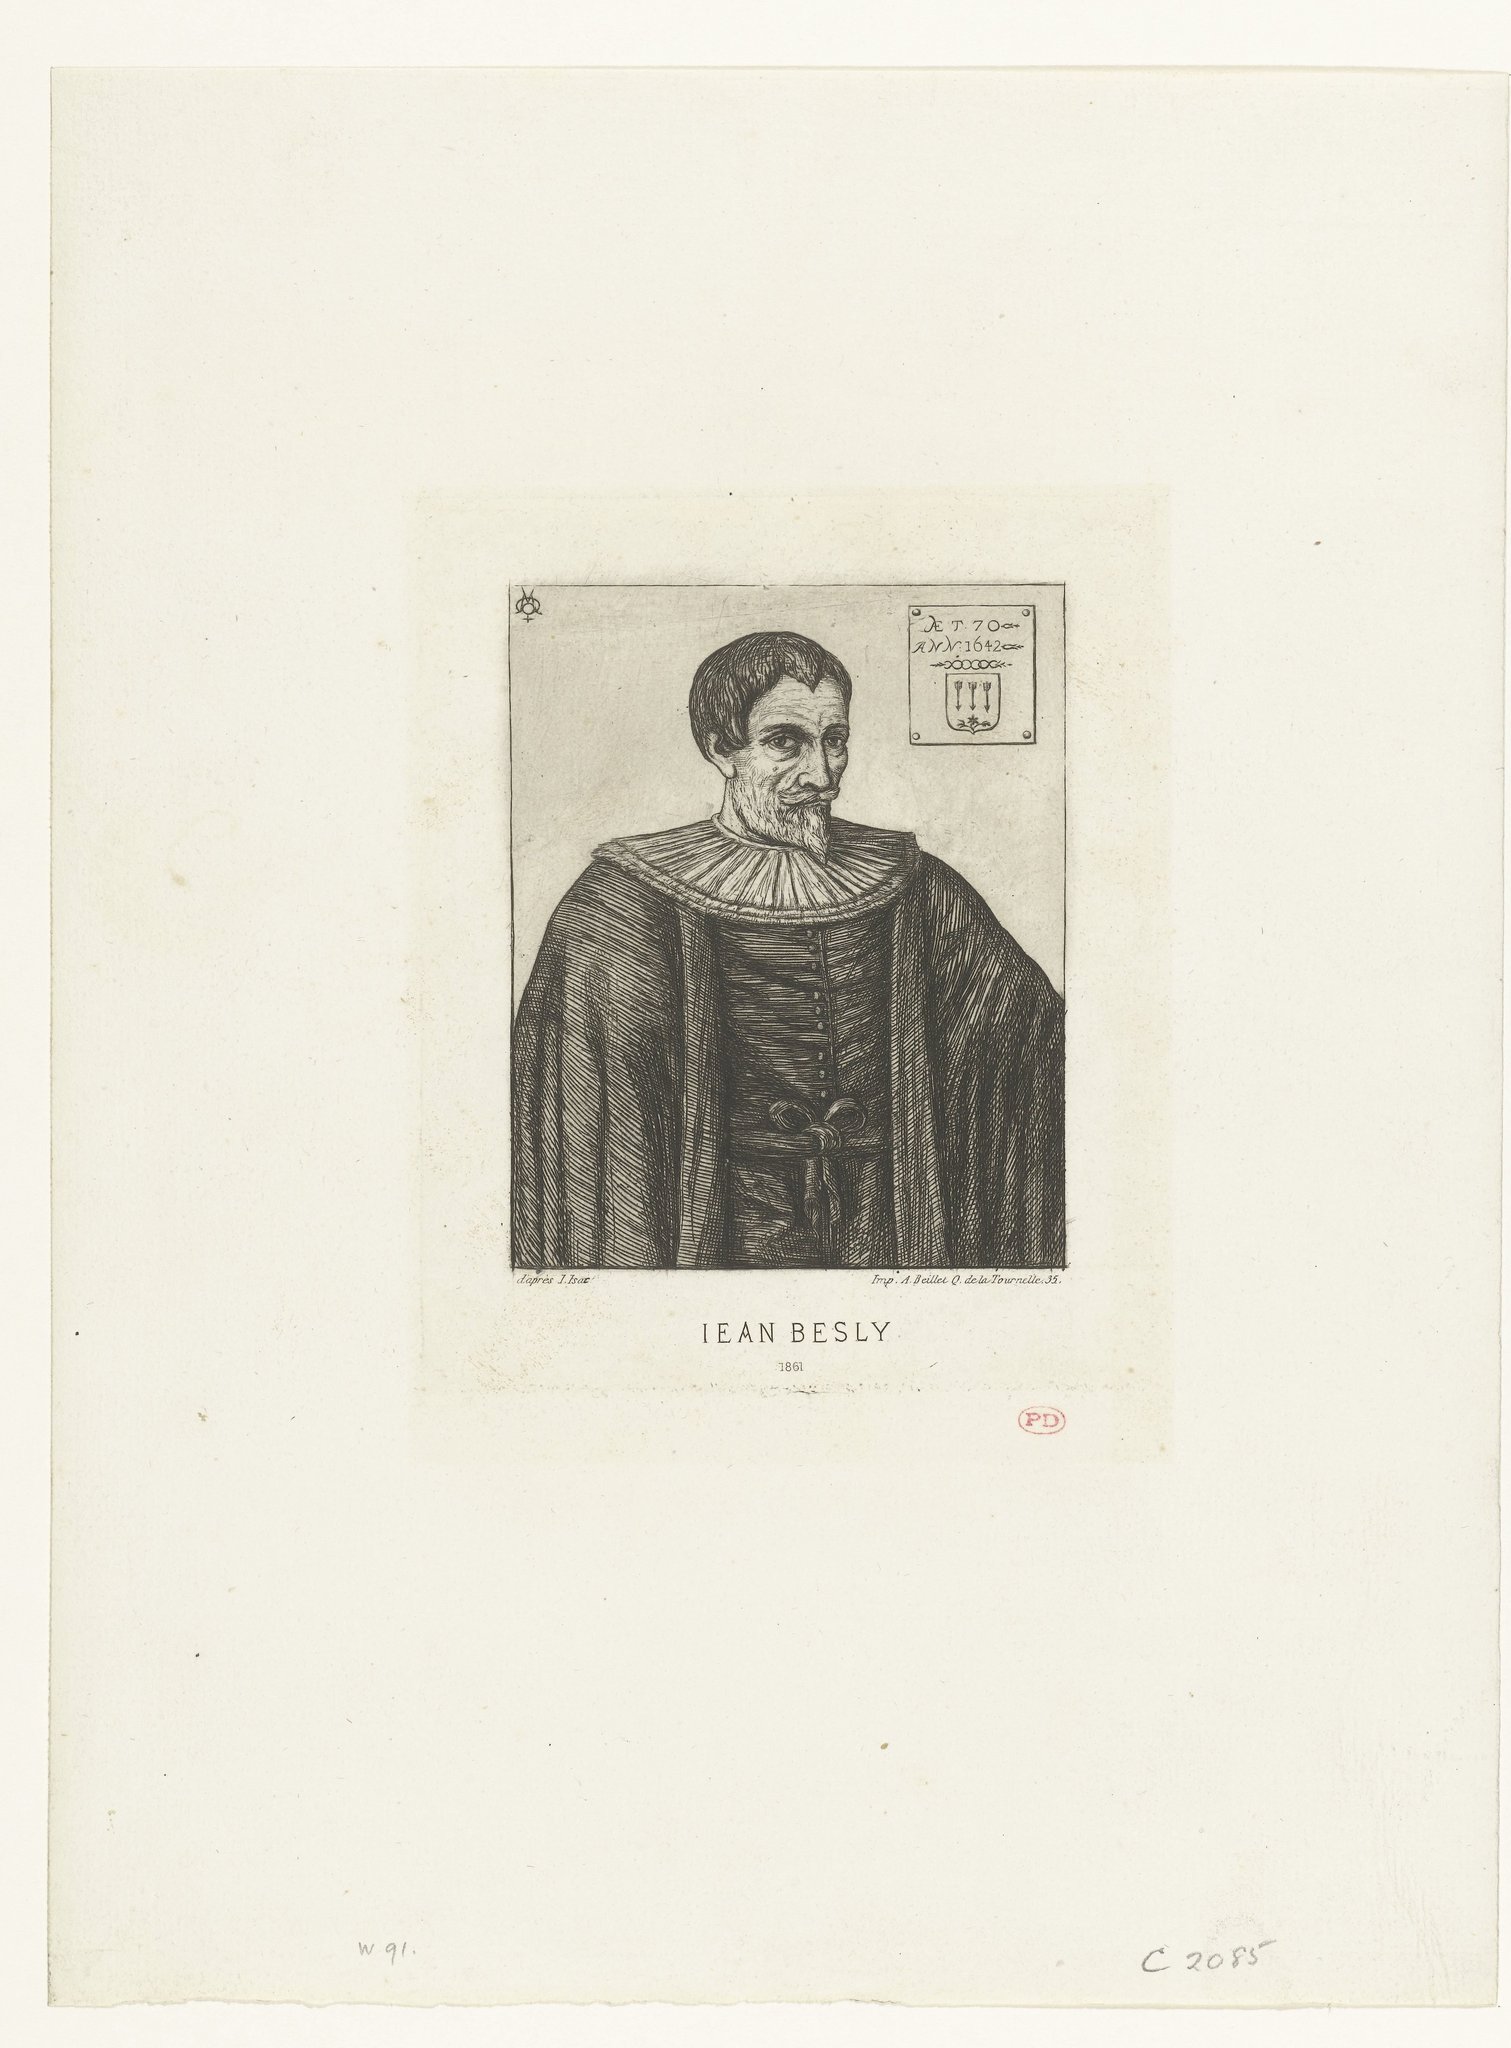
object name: print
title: Jean Besly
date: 1861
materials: paper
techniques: etching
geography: france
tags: historical disciplines; philology (+ portrait of scholar, scientist)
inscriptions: collector's mark: Lugt 2074, collector's mark: stempel R. Vroom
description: Kopie naar prent van Jaspar Isaac. Het portret van deze historicus uit de Franse provincie Poitou werd gepubliceerd in: Fillon, Benjamin & O. de Rochebrune, Poitou et Vendée, études historique et artistique (Delteil & Wright 1924, nr. 82).